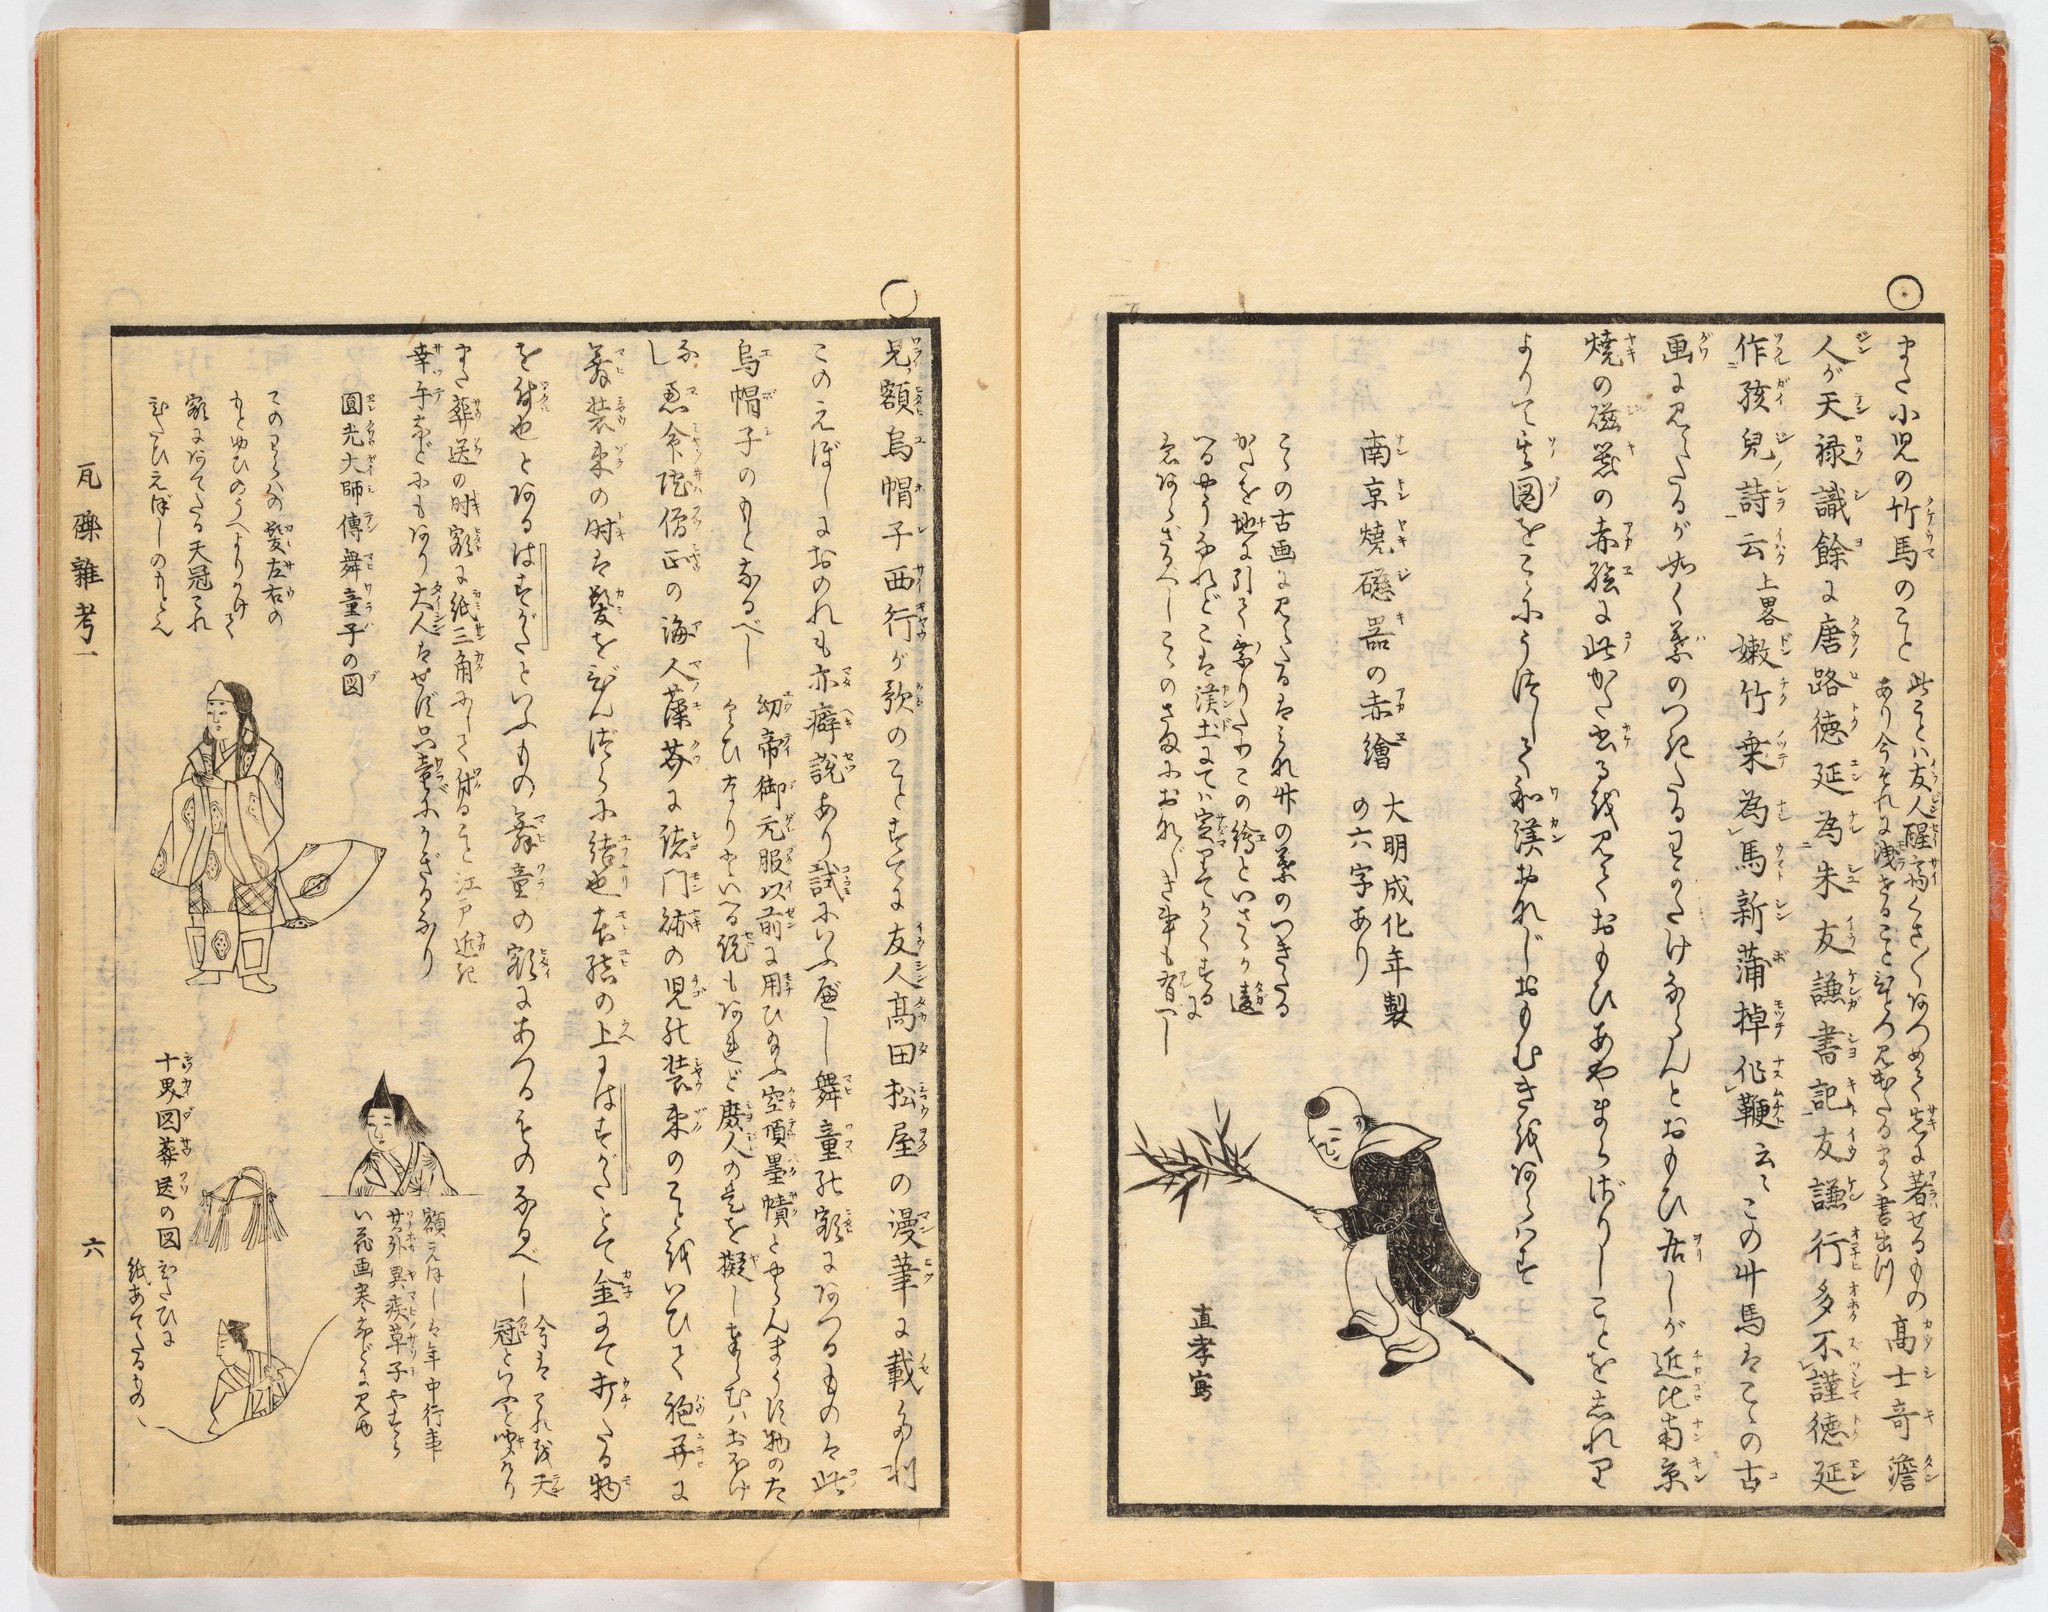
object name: illustrated book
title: Gareki zakko, Vol. 1 (notes on miscellaneous rubble)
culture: japanese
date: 1815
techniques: woodblock print